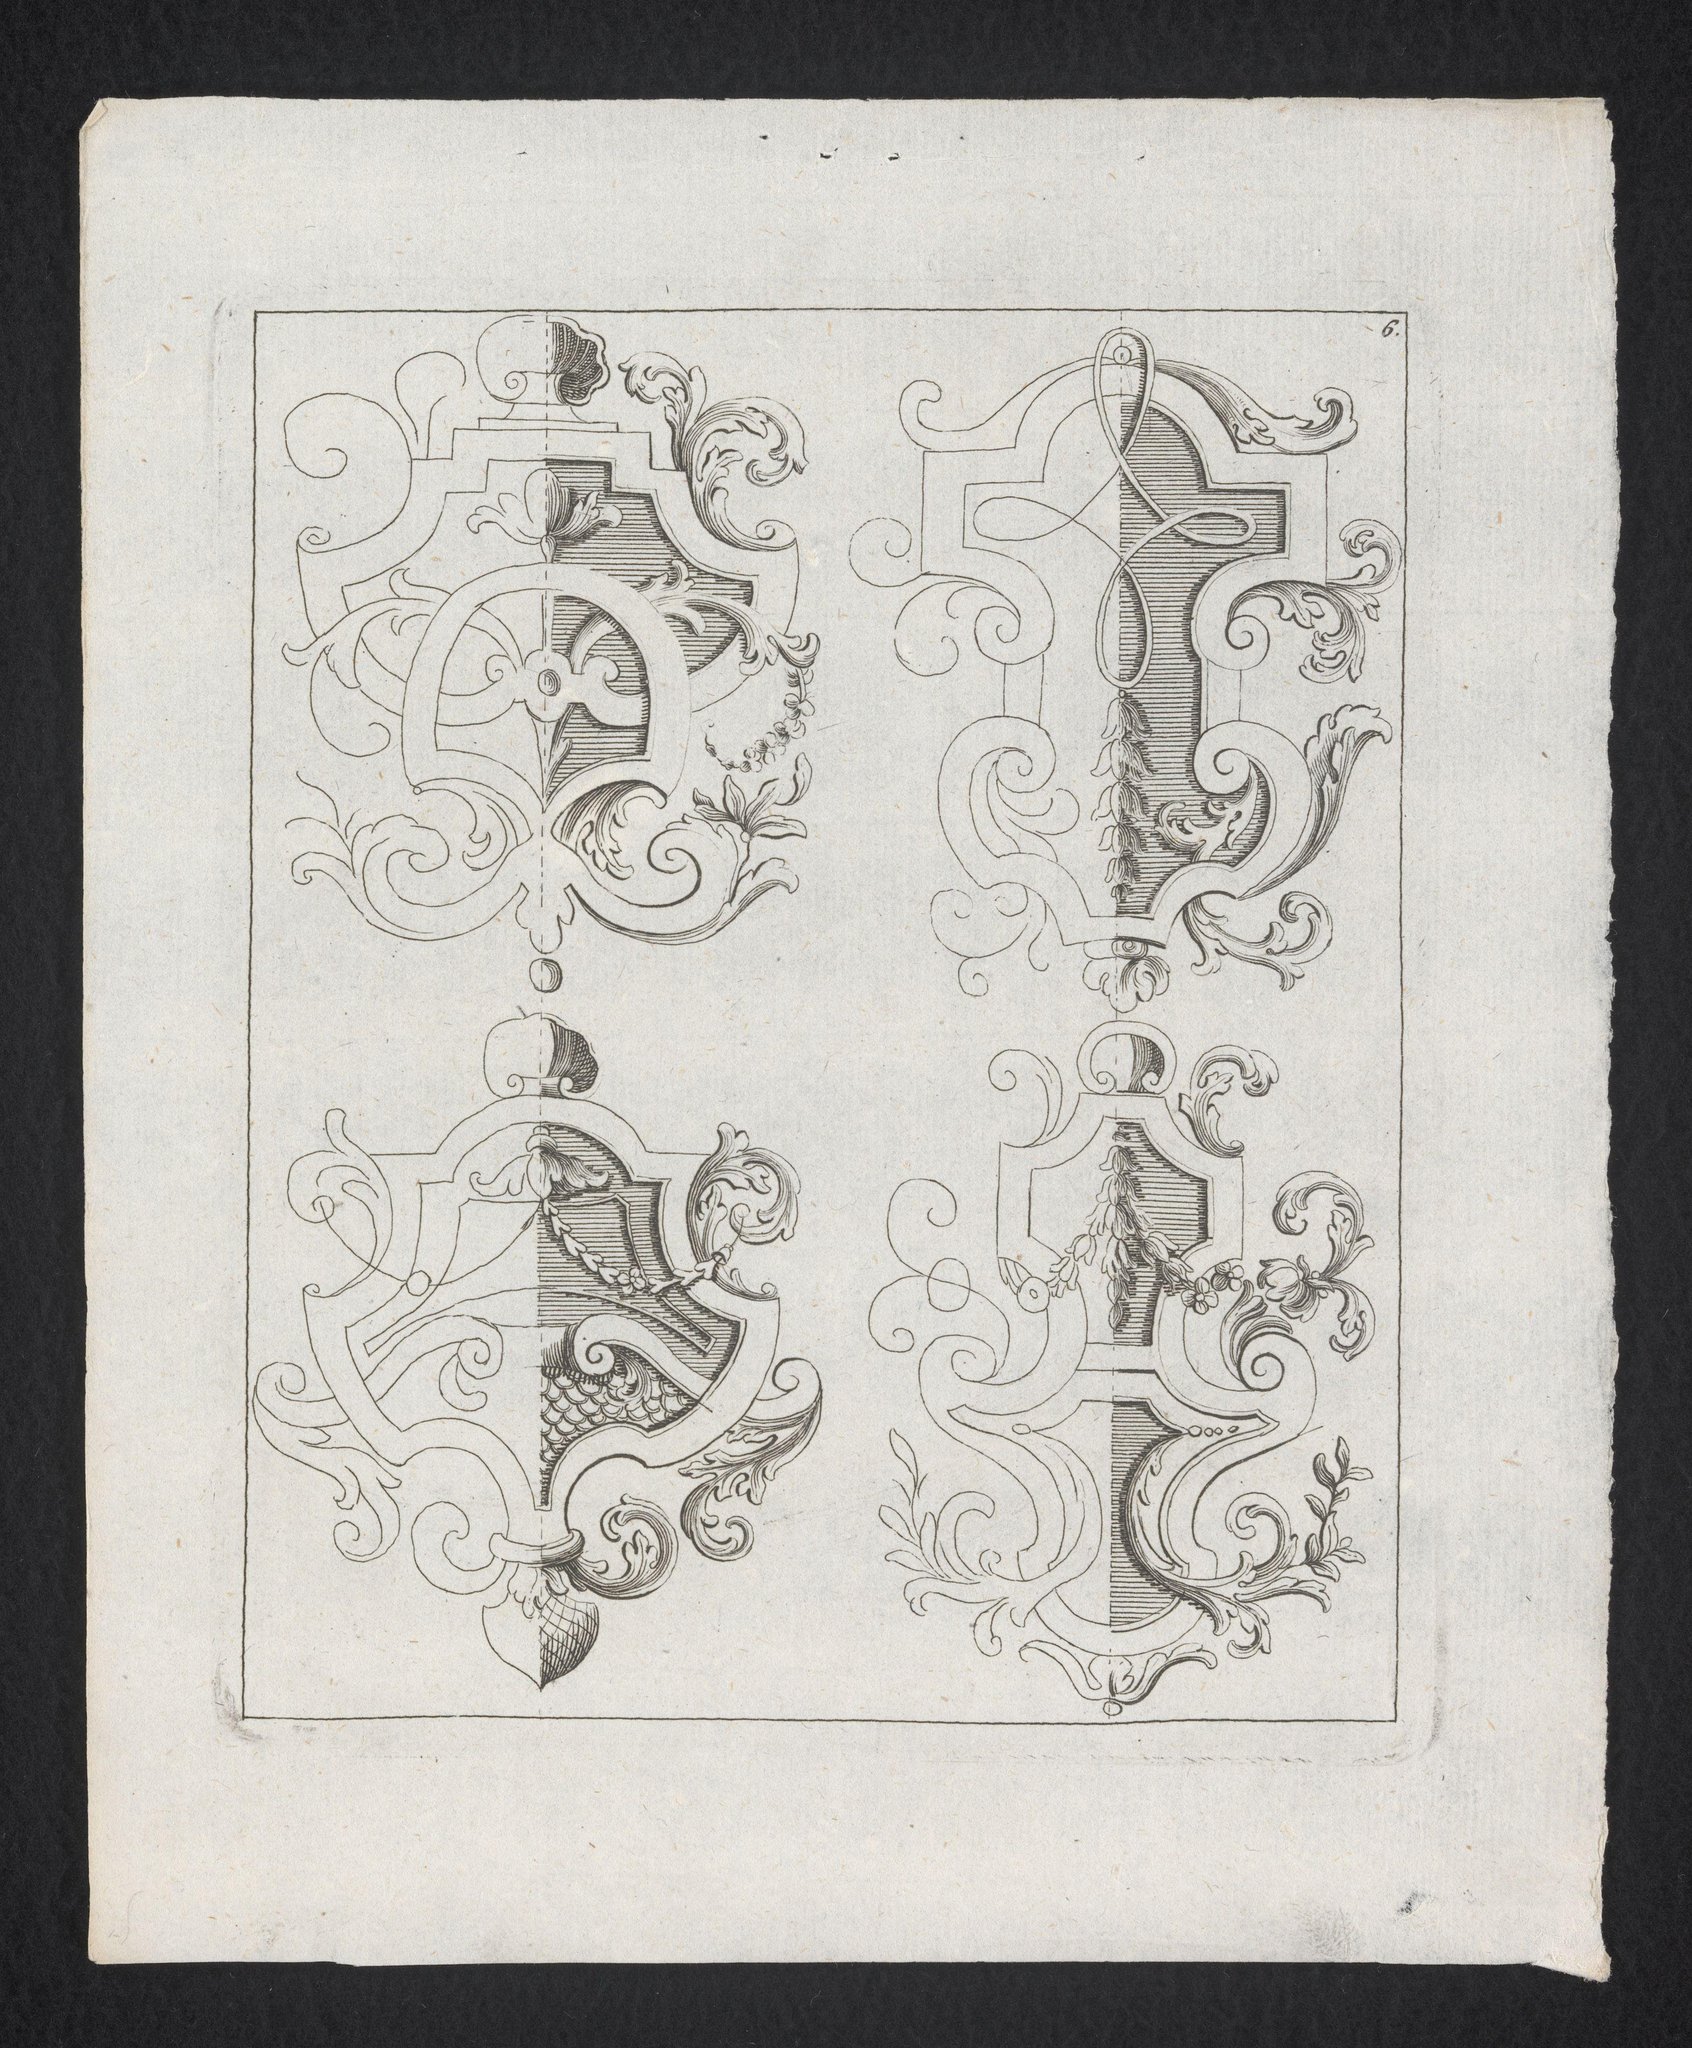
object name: print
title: Vier decoraties met vlechtwerk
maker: Anonymous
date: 1704-1737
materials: paper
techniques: engraving, etching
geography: nuremberg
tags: 'laub- und bandelwerk' ~ ornament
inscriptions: collector's mark: Lugt 2760, collector's mark: Lugt 2228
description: Vier rocaille decoraties met vlechtwerk, bladmotieven en guirlandes, met lijntekeningen.